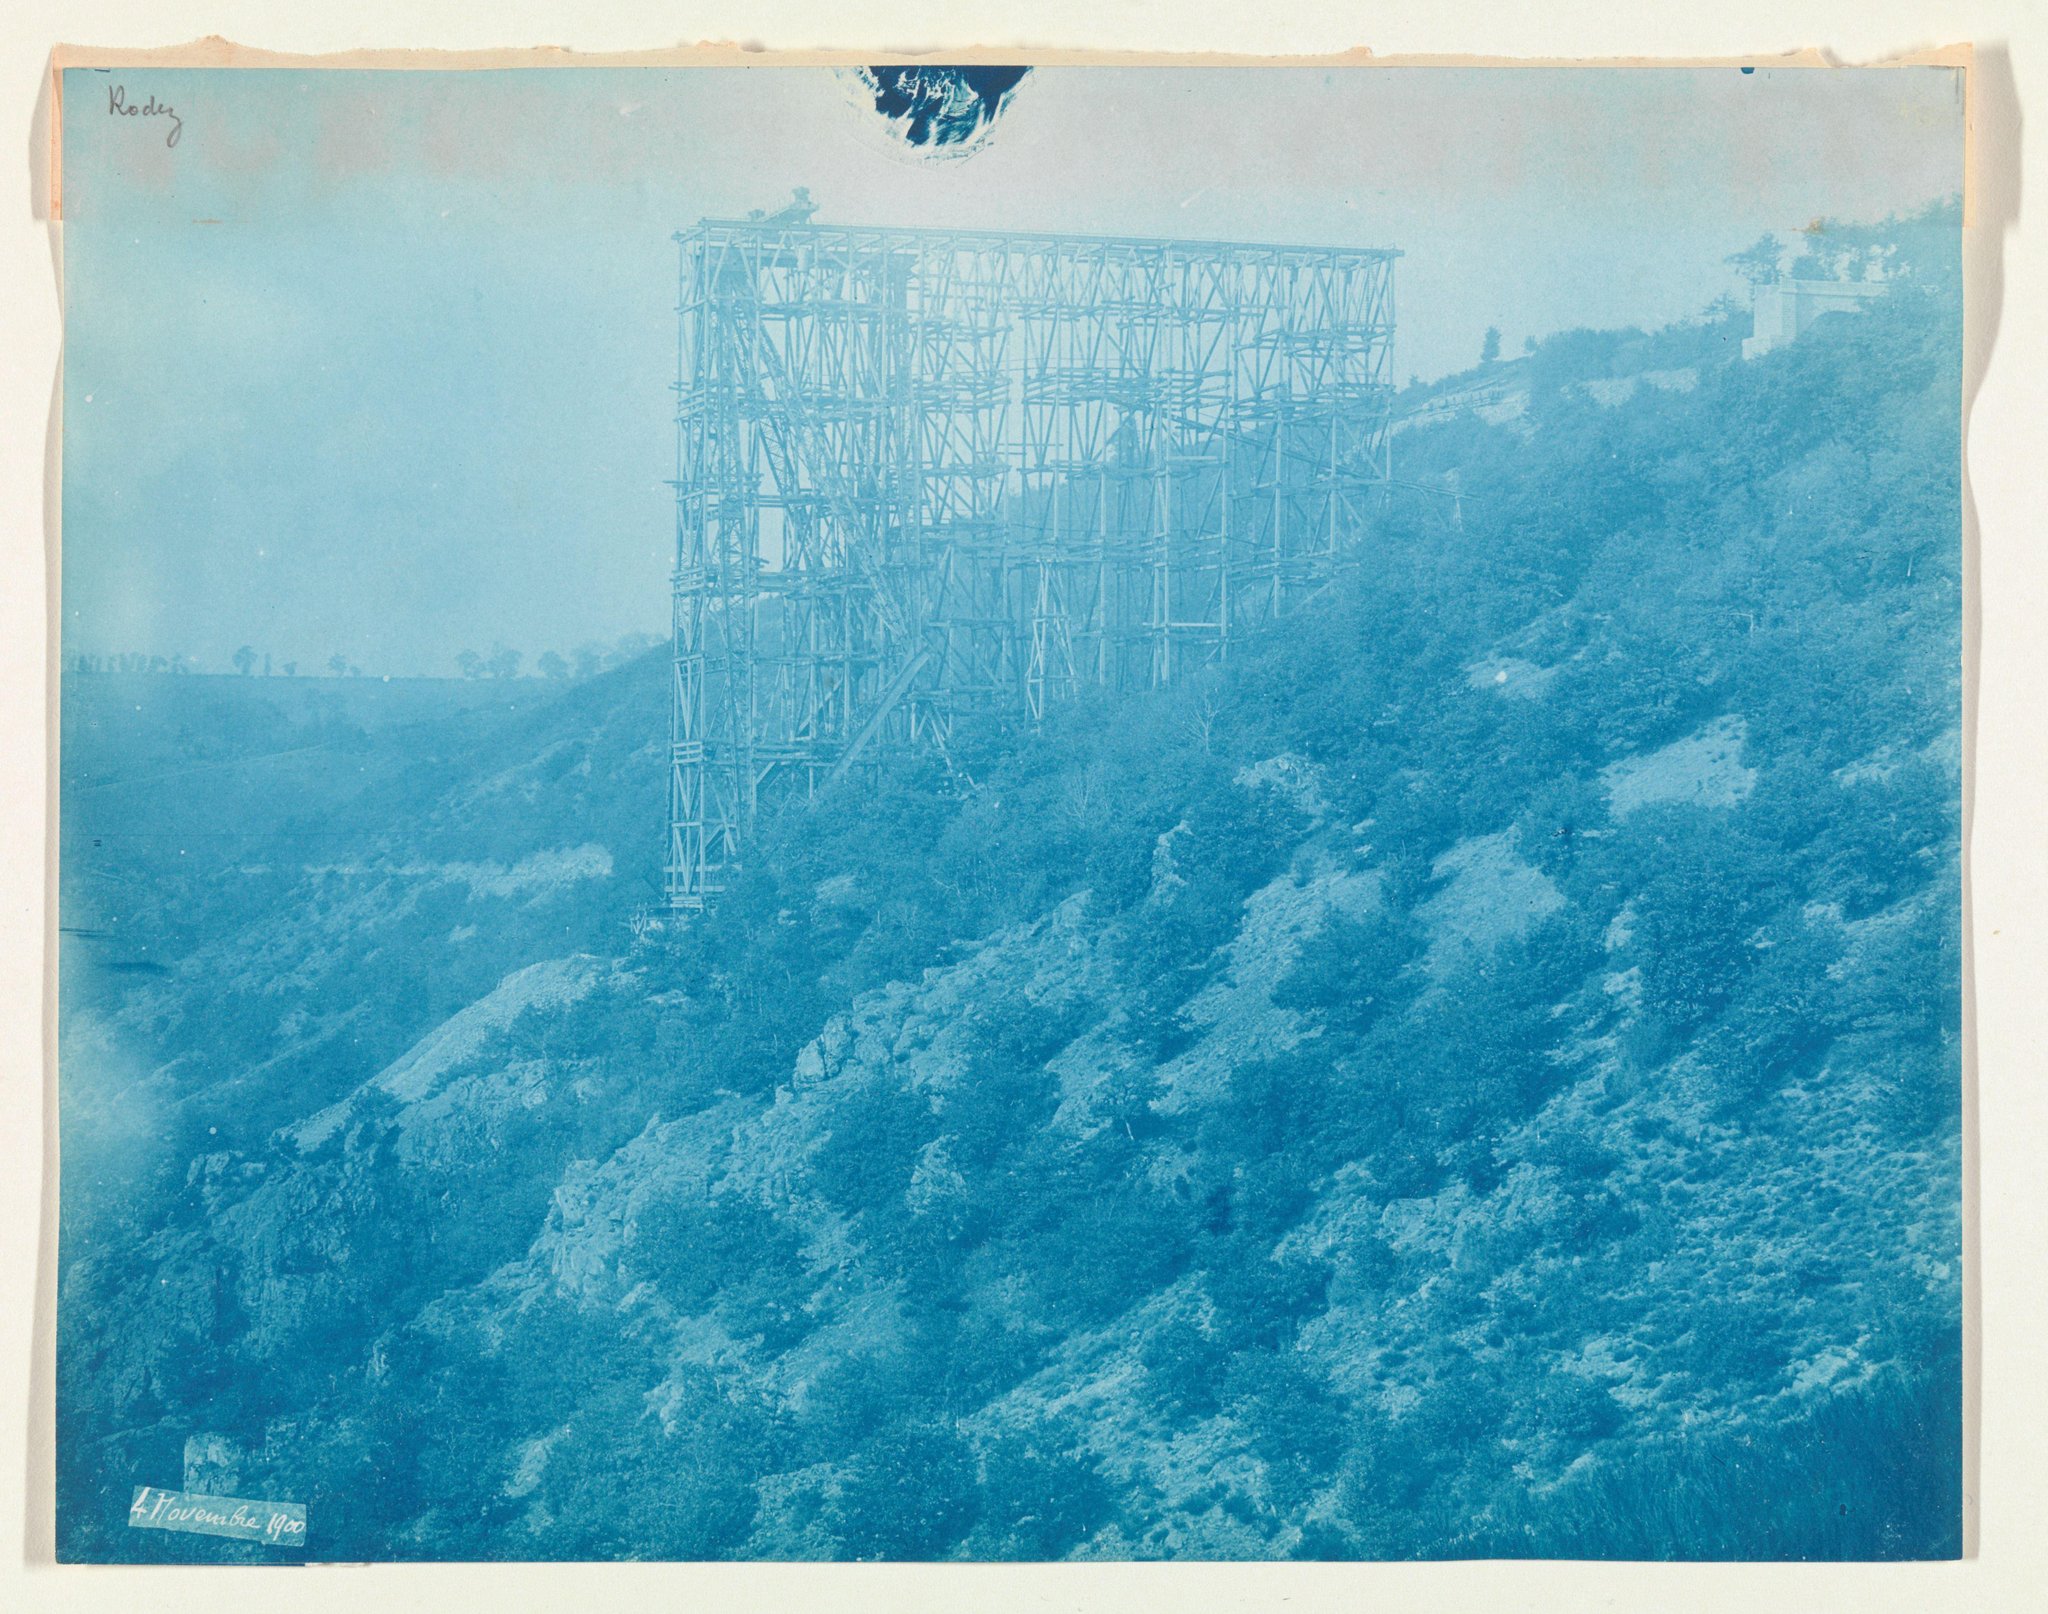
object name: photograph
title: Aanleg van het Viaur Viaduct in Frankrijk door de Societé de Construction des Battignolles, 4 november 1900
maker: Anonymous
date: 1900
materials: photographic support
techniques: cyanotype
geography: france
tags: viaduct, making the overground structures (~ building activities)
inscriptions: inscription: ‘Rodez’